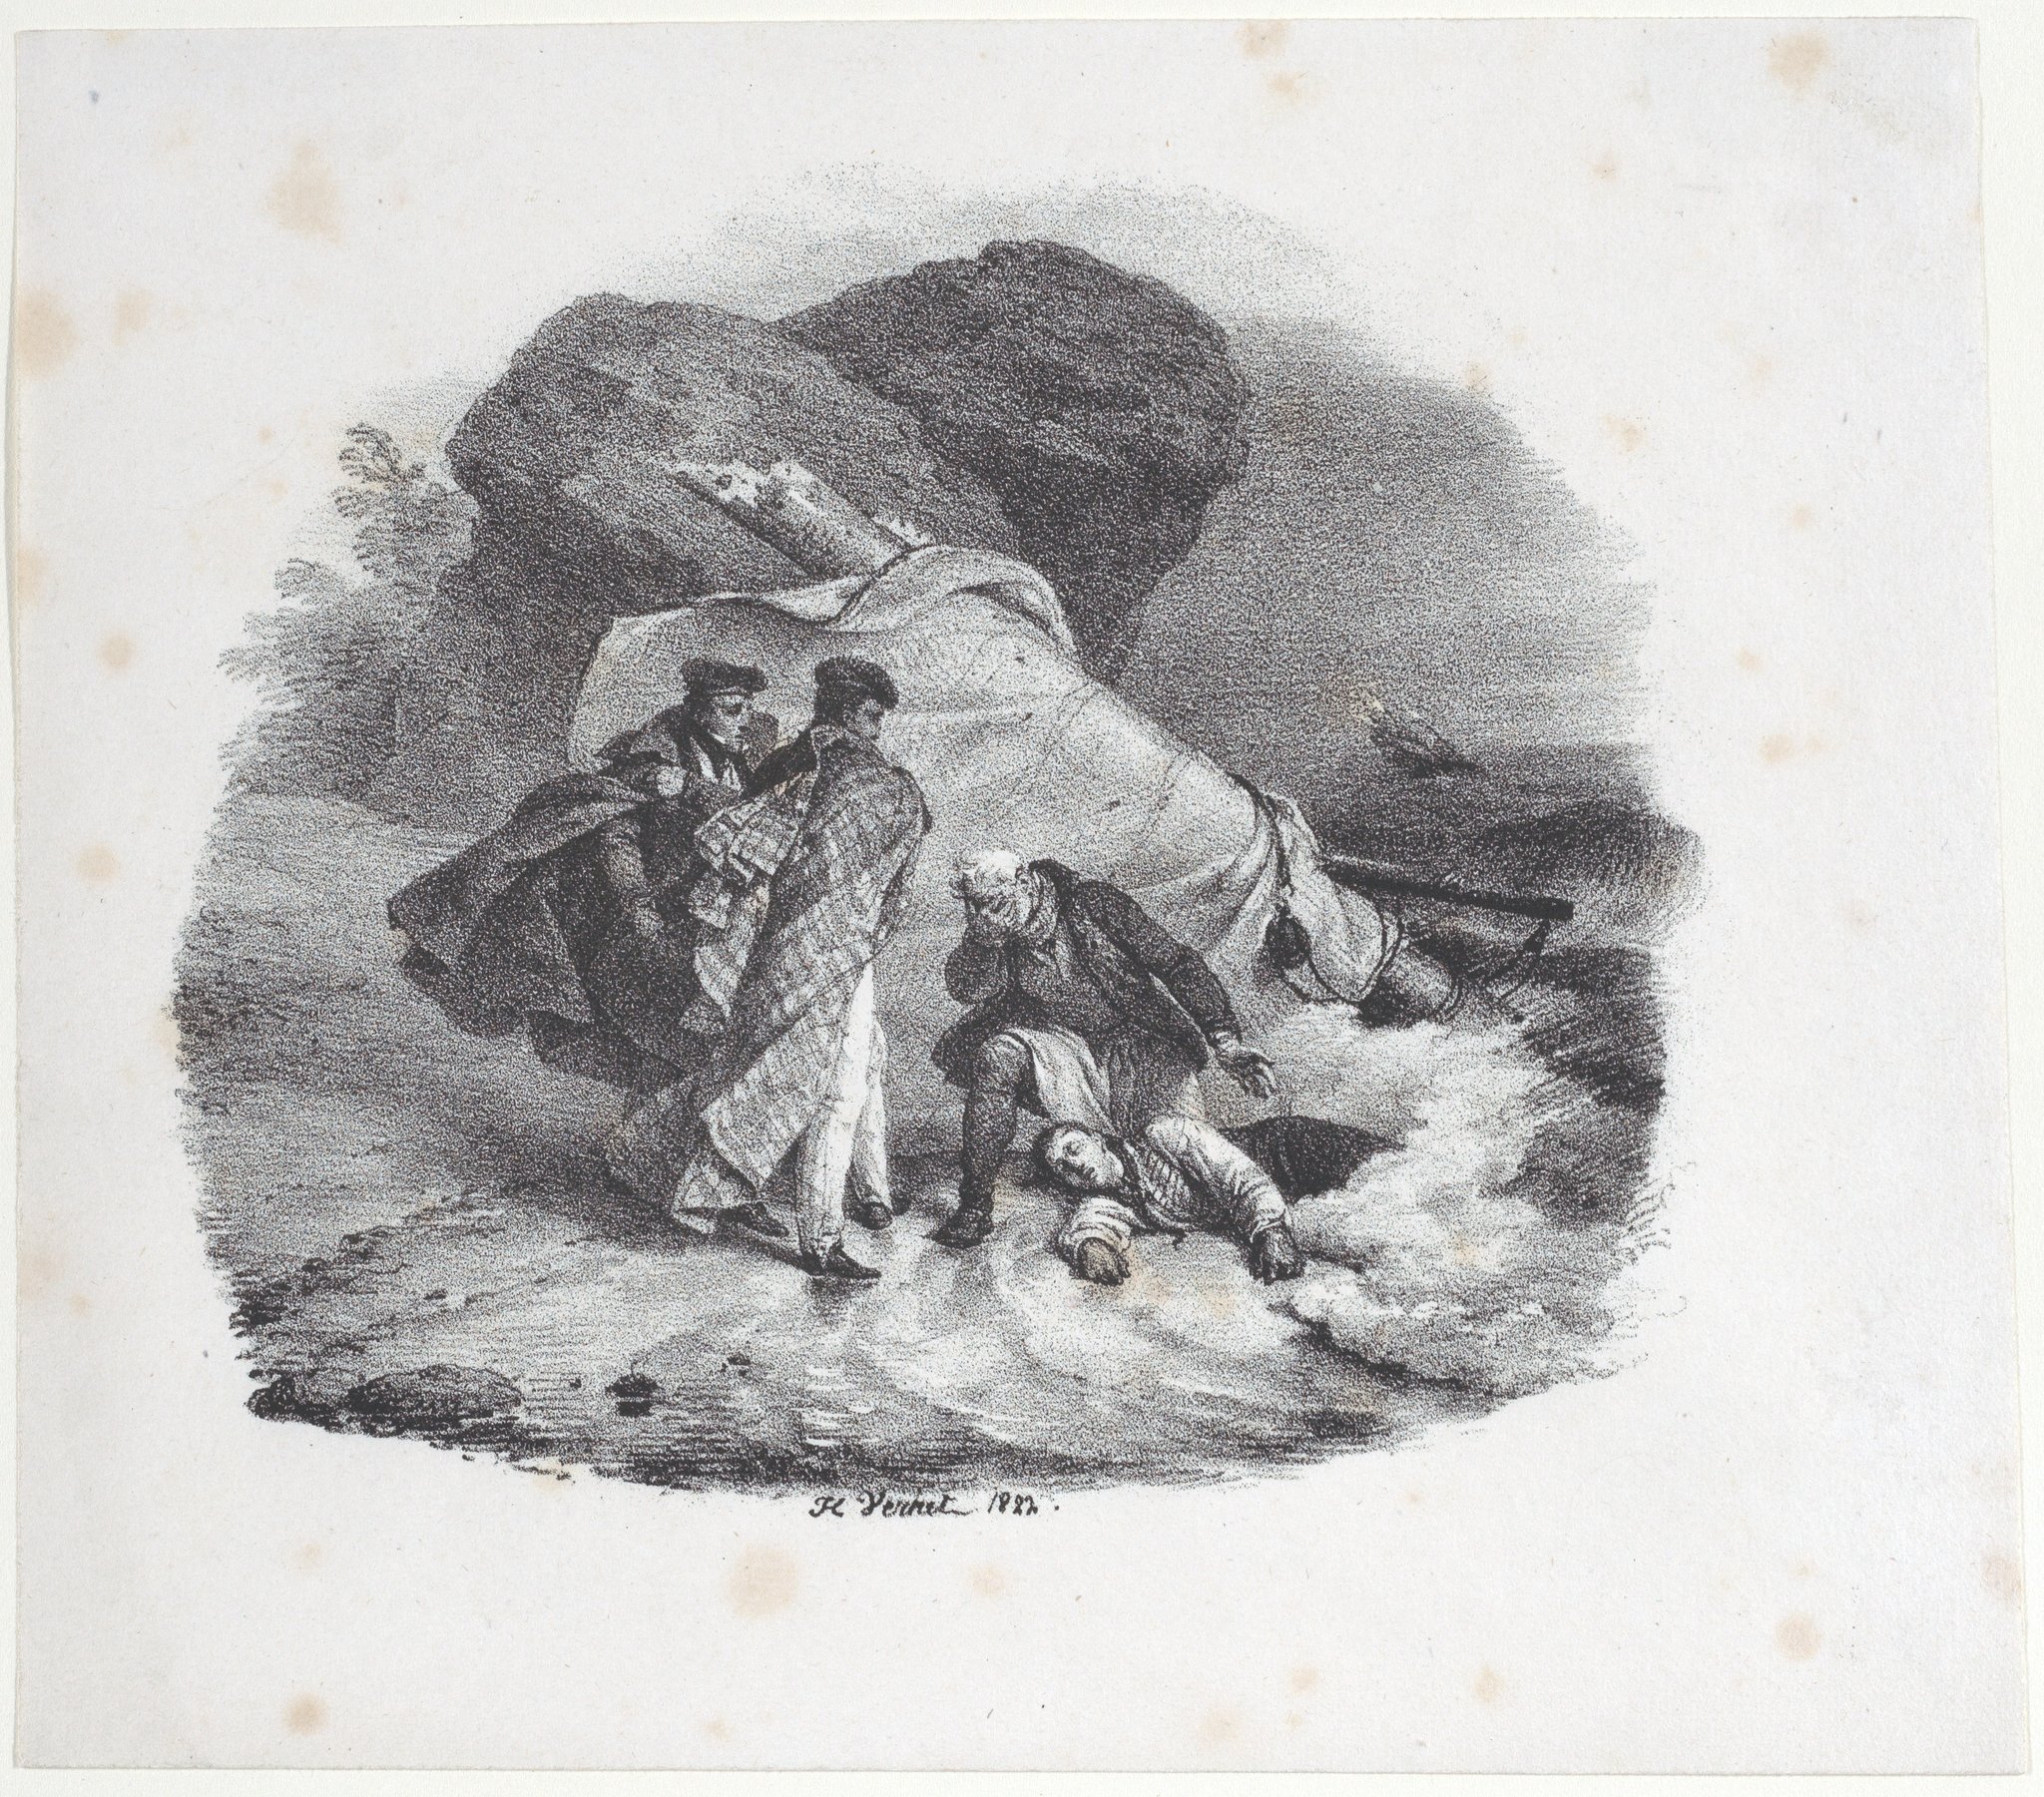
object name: print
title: Shipwrecked Victim Thrown onto the Shore of Pourville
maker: horace vernet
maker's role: artist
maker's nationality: french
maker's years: 1789-1863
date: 1822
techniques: lithograph